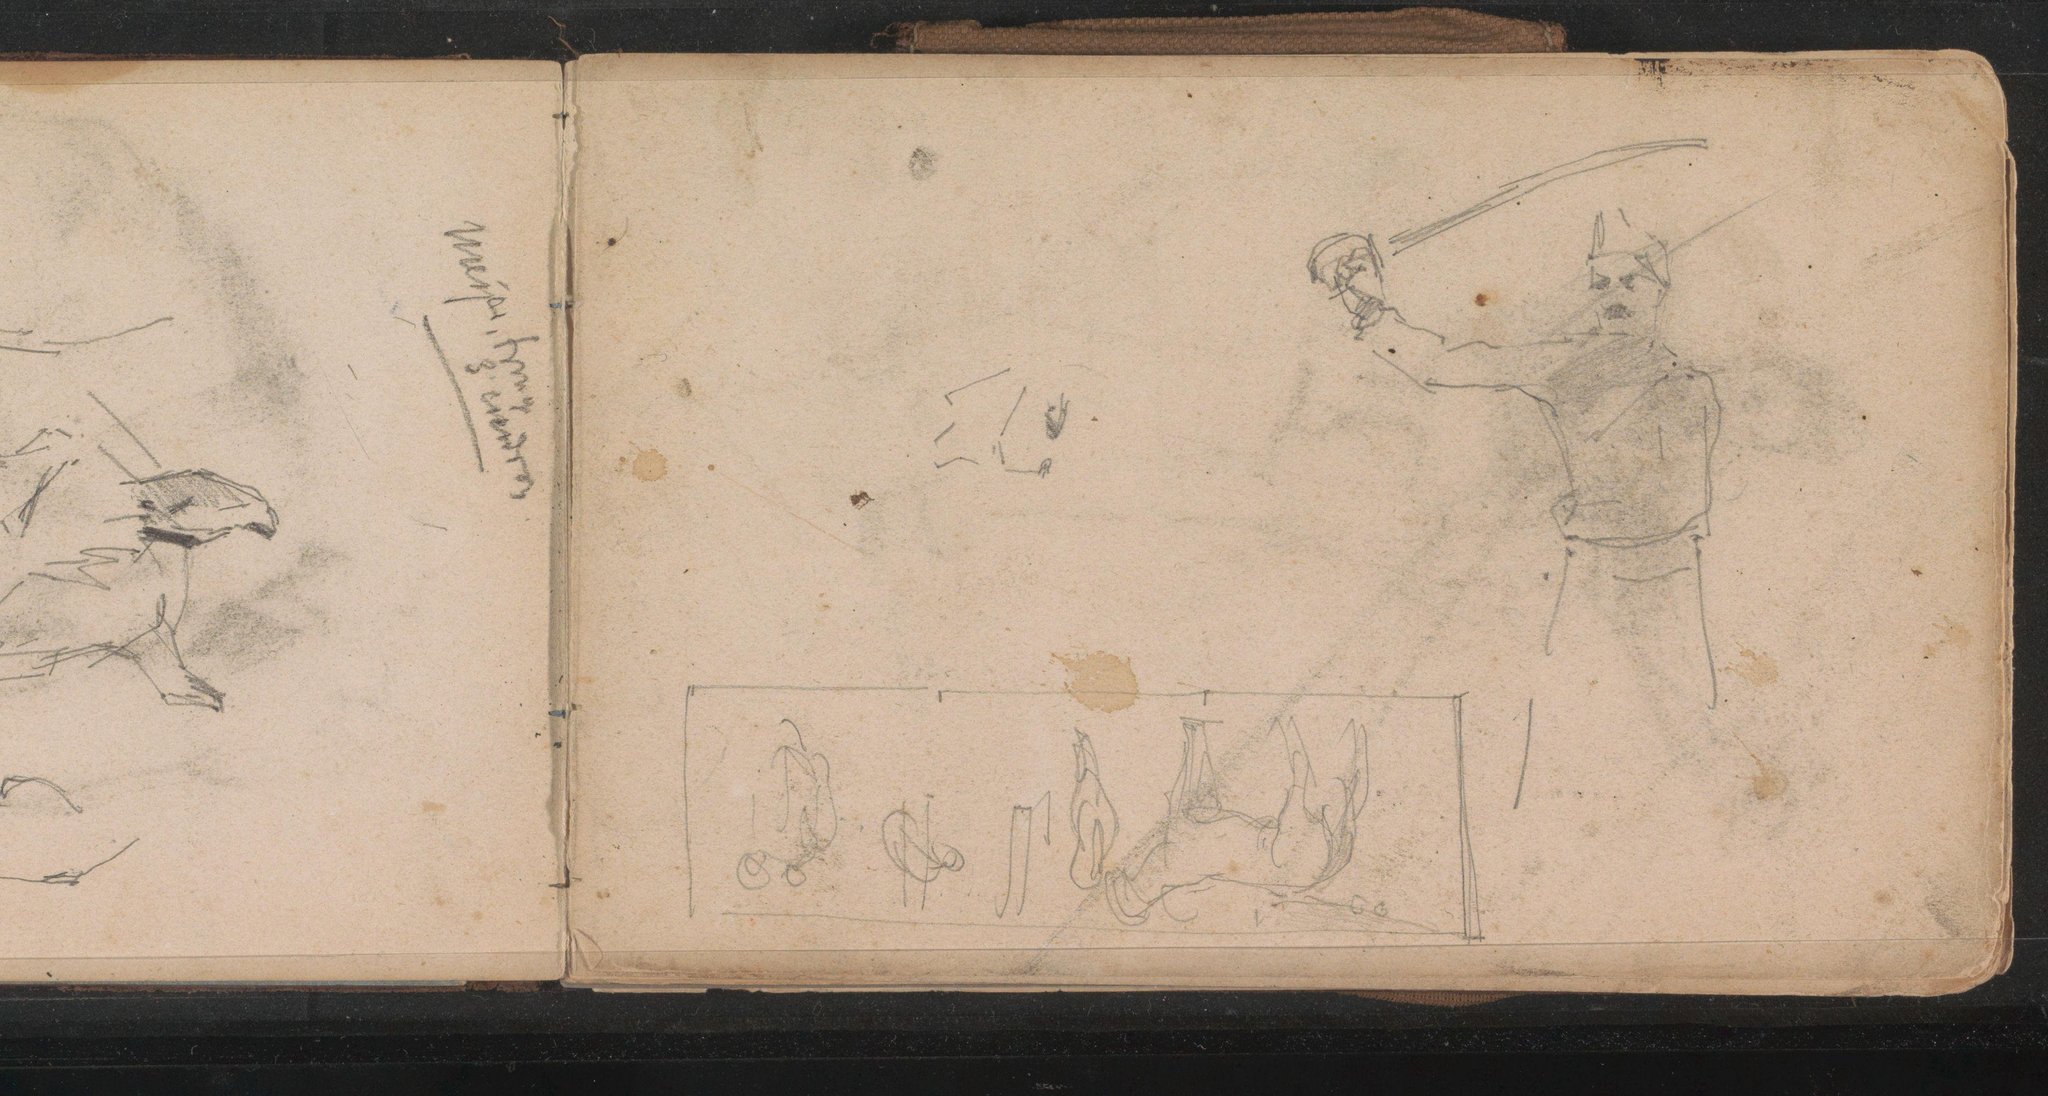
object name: sketchbook leaf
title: Soldaat en een compositiestudie met paarden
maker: george hendrik breitner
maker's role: draughtsman, painter, print maker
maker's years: 1857-1923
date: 1880-1882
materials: paper, pencil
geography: scheveningen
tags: sabre (~ fencing), hacking and thrusting weapons, the soldier; the soldier's life, horse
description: Soldaat met opgeheven sabel. Pagina 4 uit een schetsboek met 37 bladen.